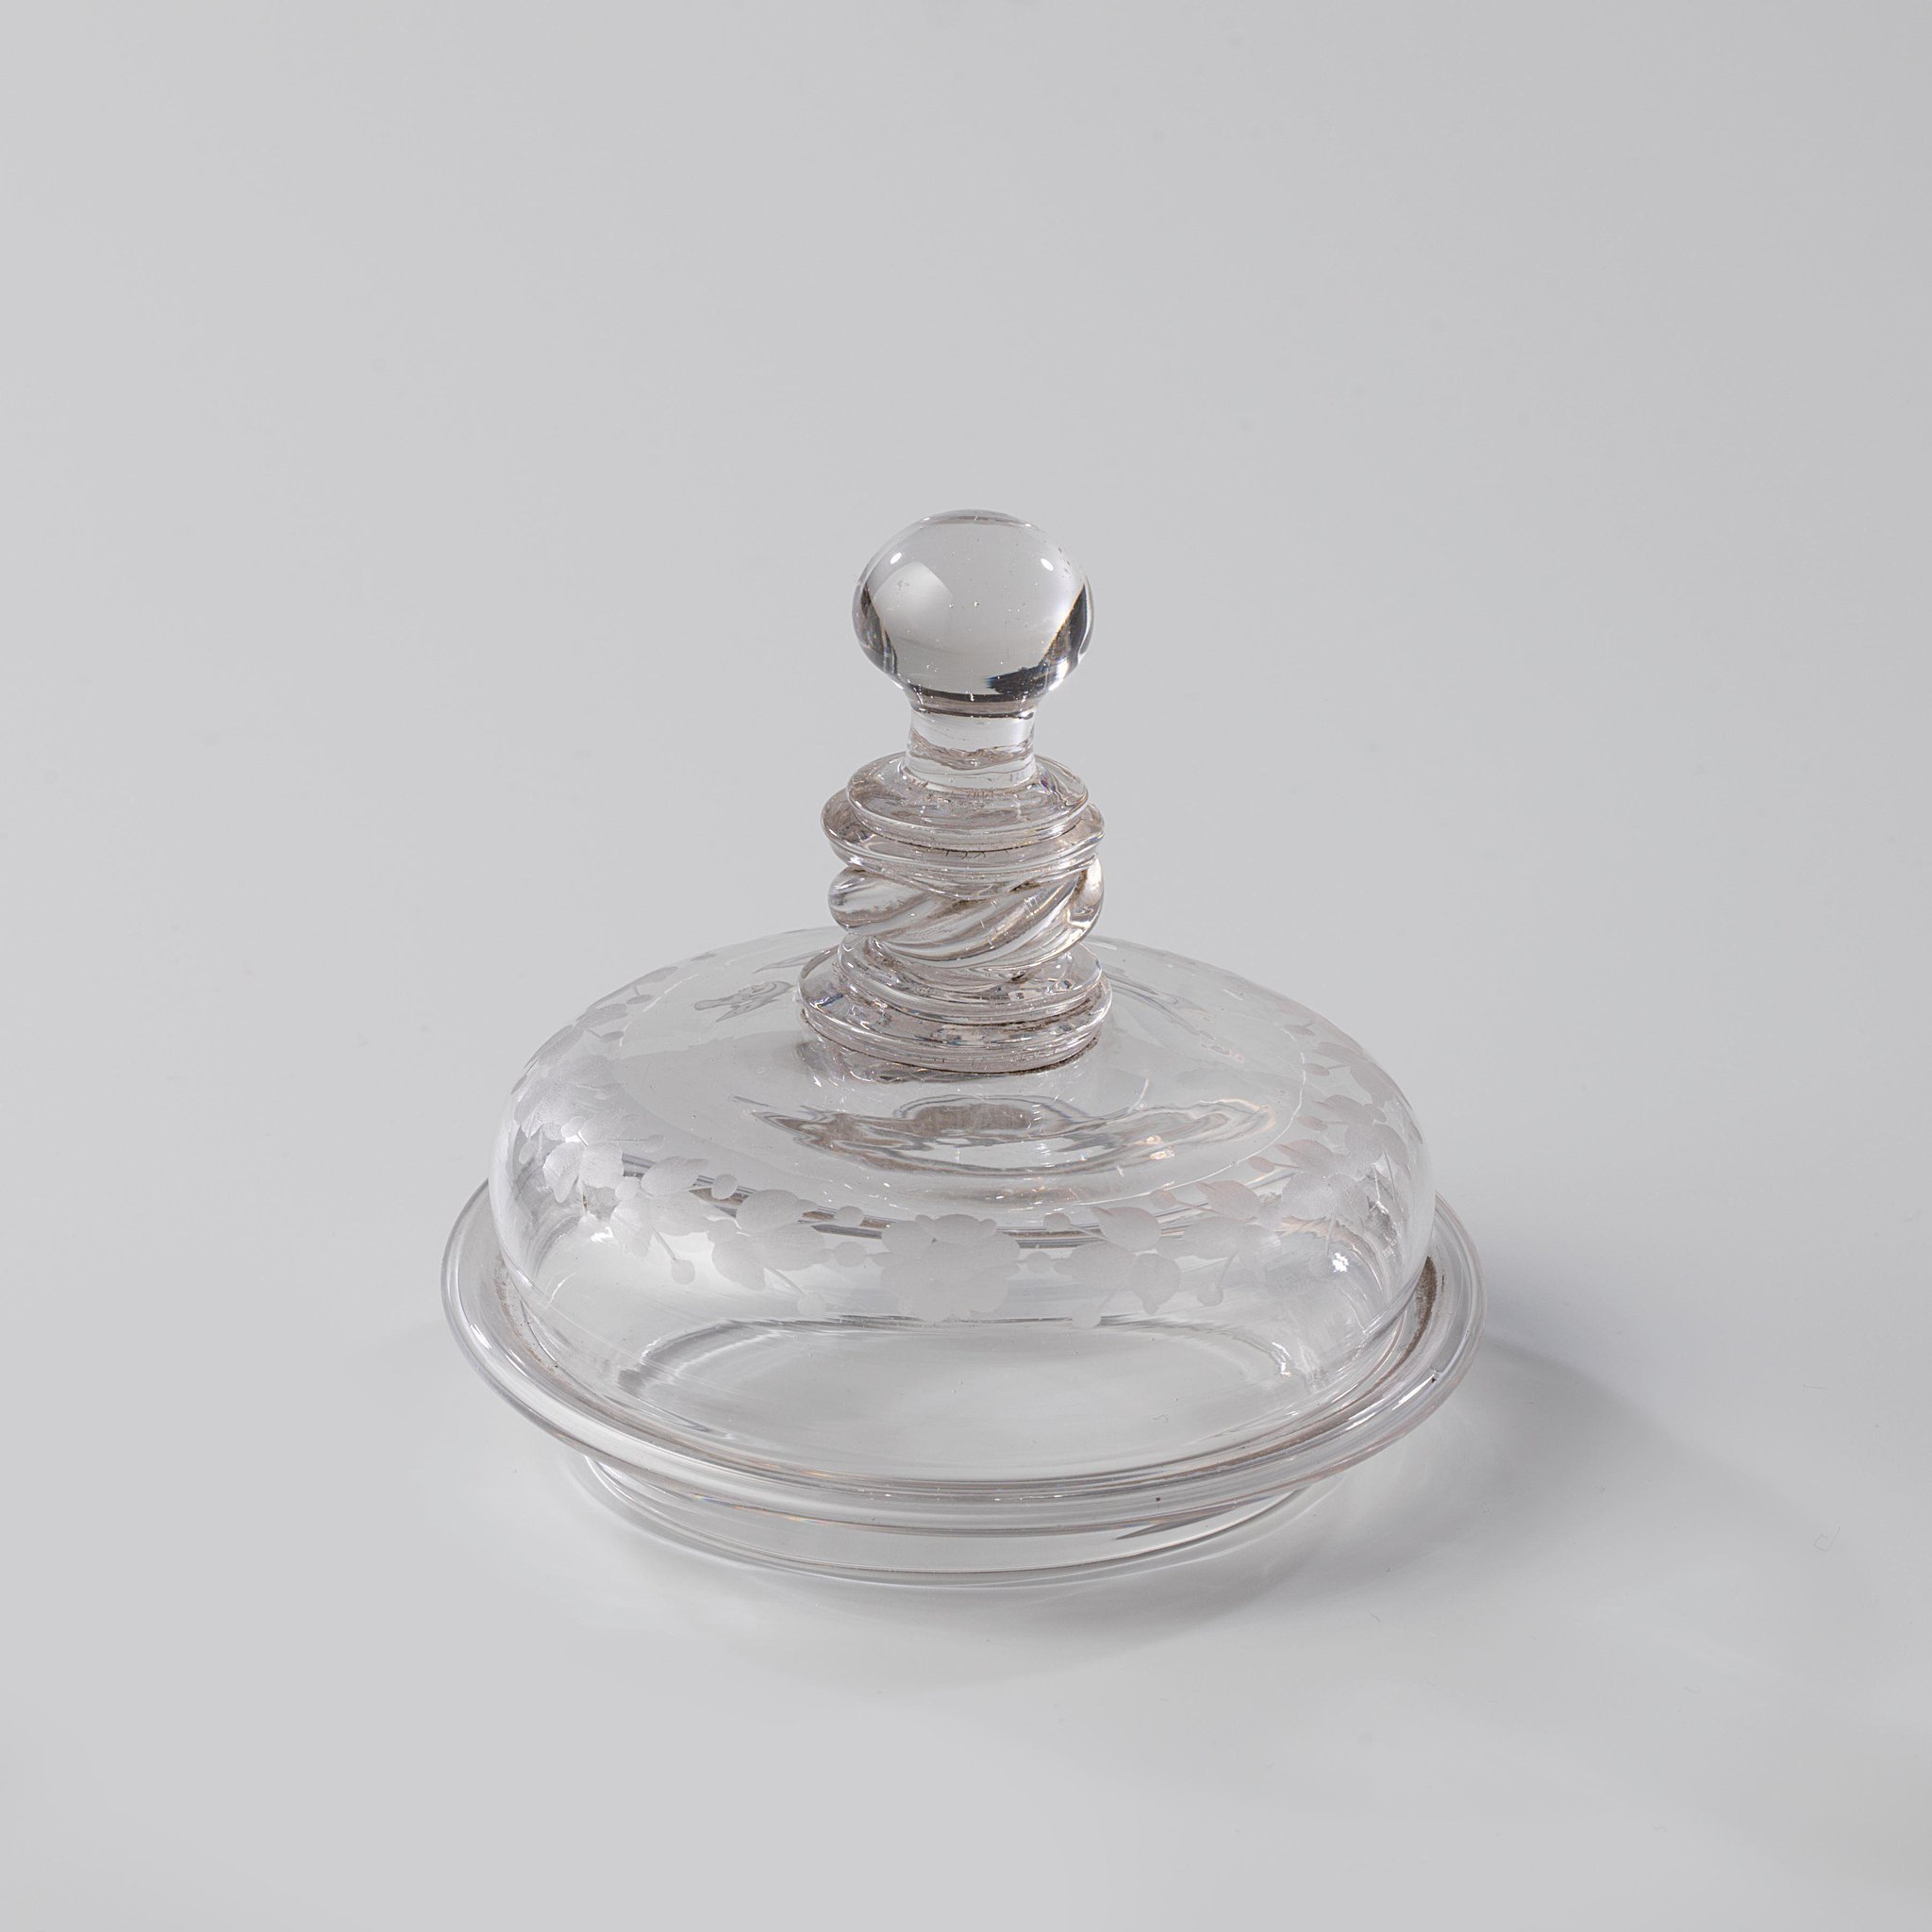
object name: lid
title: Deksel van een bokaal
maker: Anonymous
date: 1750-1775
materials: glass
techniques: glassblowing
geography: thuringia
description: Gewelfde deksel, bekroond met gelede dekselknop, bestaande uit een gedraaide knop tussen vier schijven en een bolvormige uiteinde. Op de deksel rondlopend een gegraveerde bloem- en bladslinger.